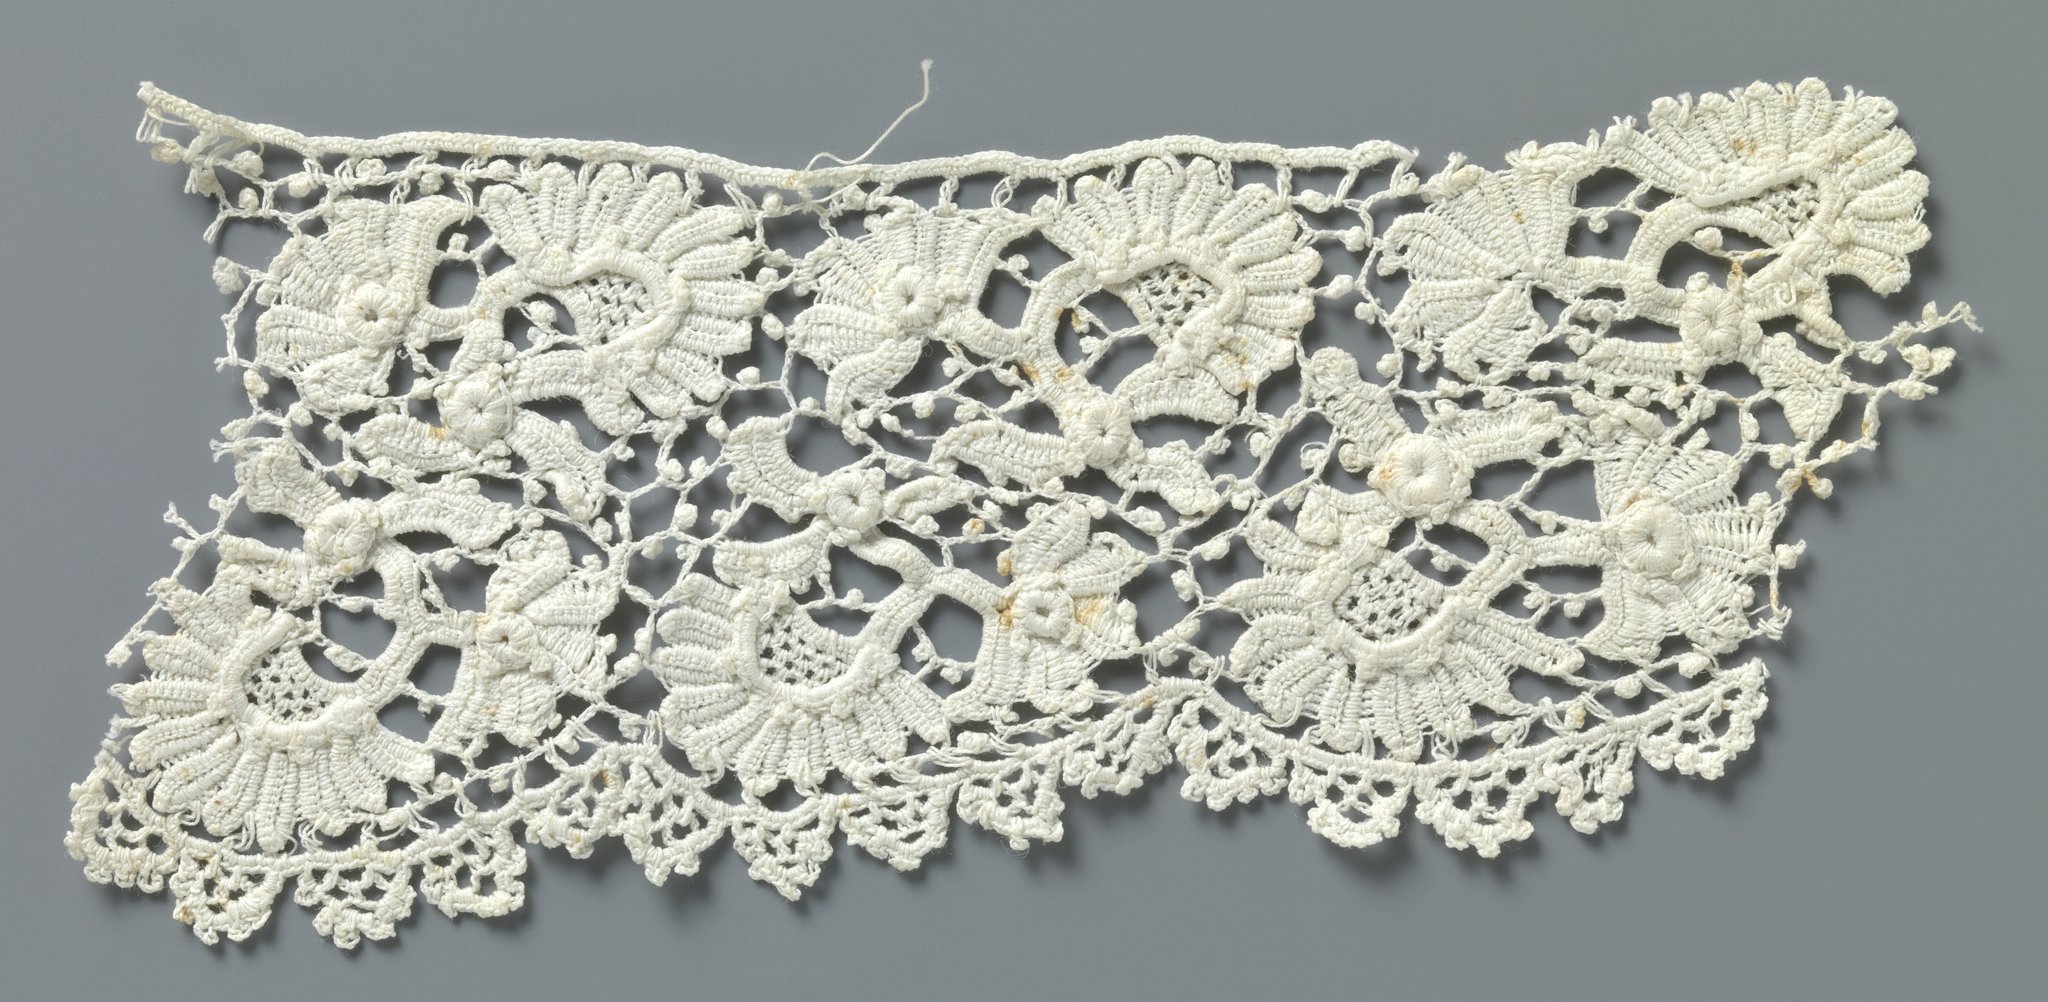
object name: strip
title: Strook gehaakte kant met waaiervormige bloemen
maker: Anonymous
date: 1890-1909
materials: cotton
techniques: crocheted lace, irish crochet lace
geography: ireland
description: Het is een aanname dat deze Ierse gehaakte kant ook daadwerkelijk in Ierland is gemaakt. Ierse gehaakte kant kent zijn oorsprong rond 1760 en kwam vanaf 1840 in ontwikkeling. Aangezien volgens Martine Bruggeman (Kant in Europa) de Ierse haakindustrie aan het eind van de 19e eeuw gereorganiseerd werd en in populariteit groeide, is het hier beschreven stuk gedateerd rond 1890, tot 1909 vanwege de datering in het eerste decennium van populariteit van Ierse gehaakte kant volgens het Kantlexicon (Johan Coene).